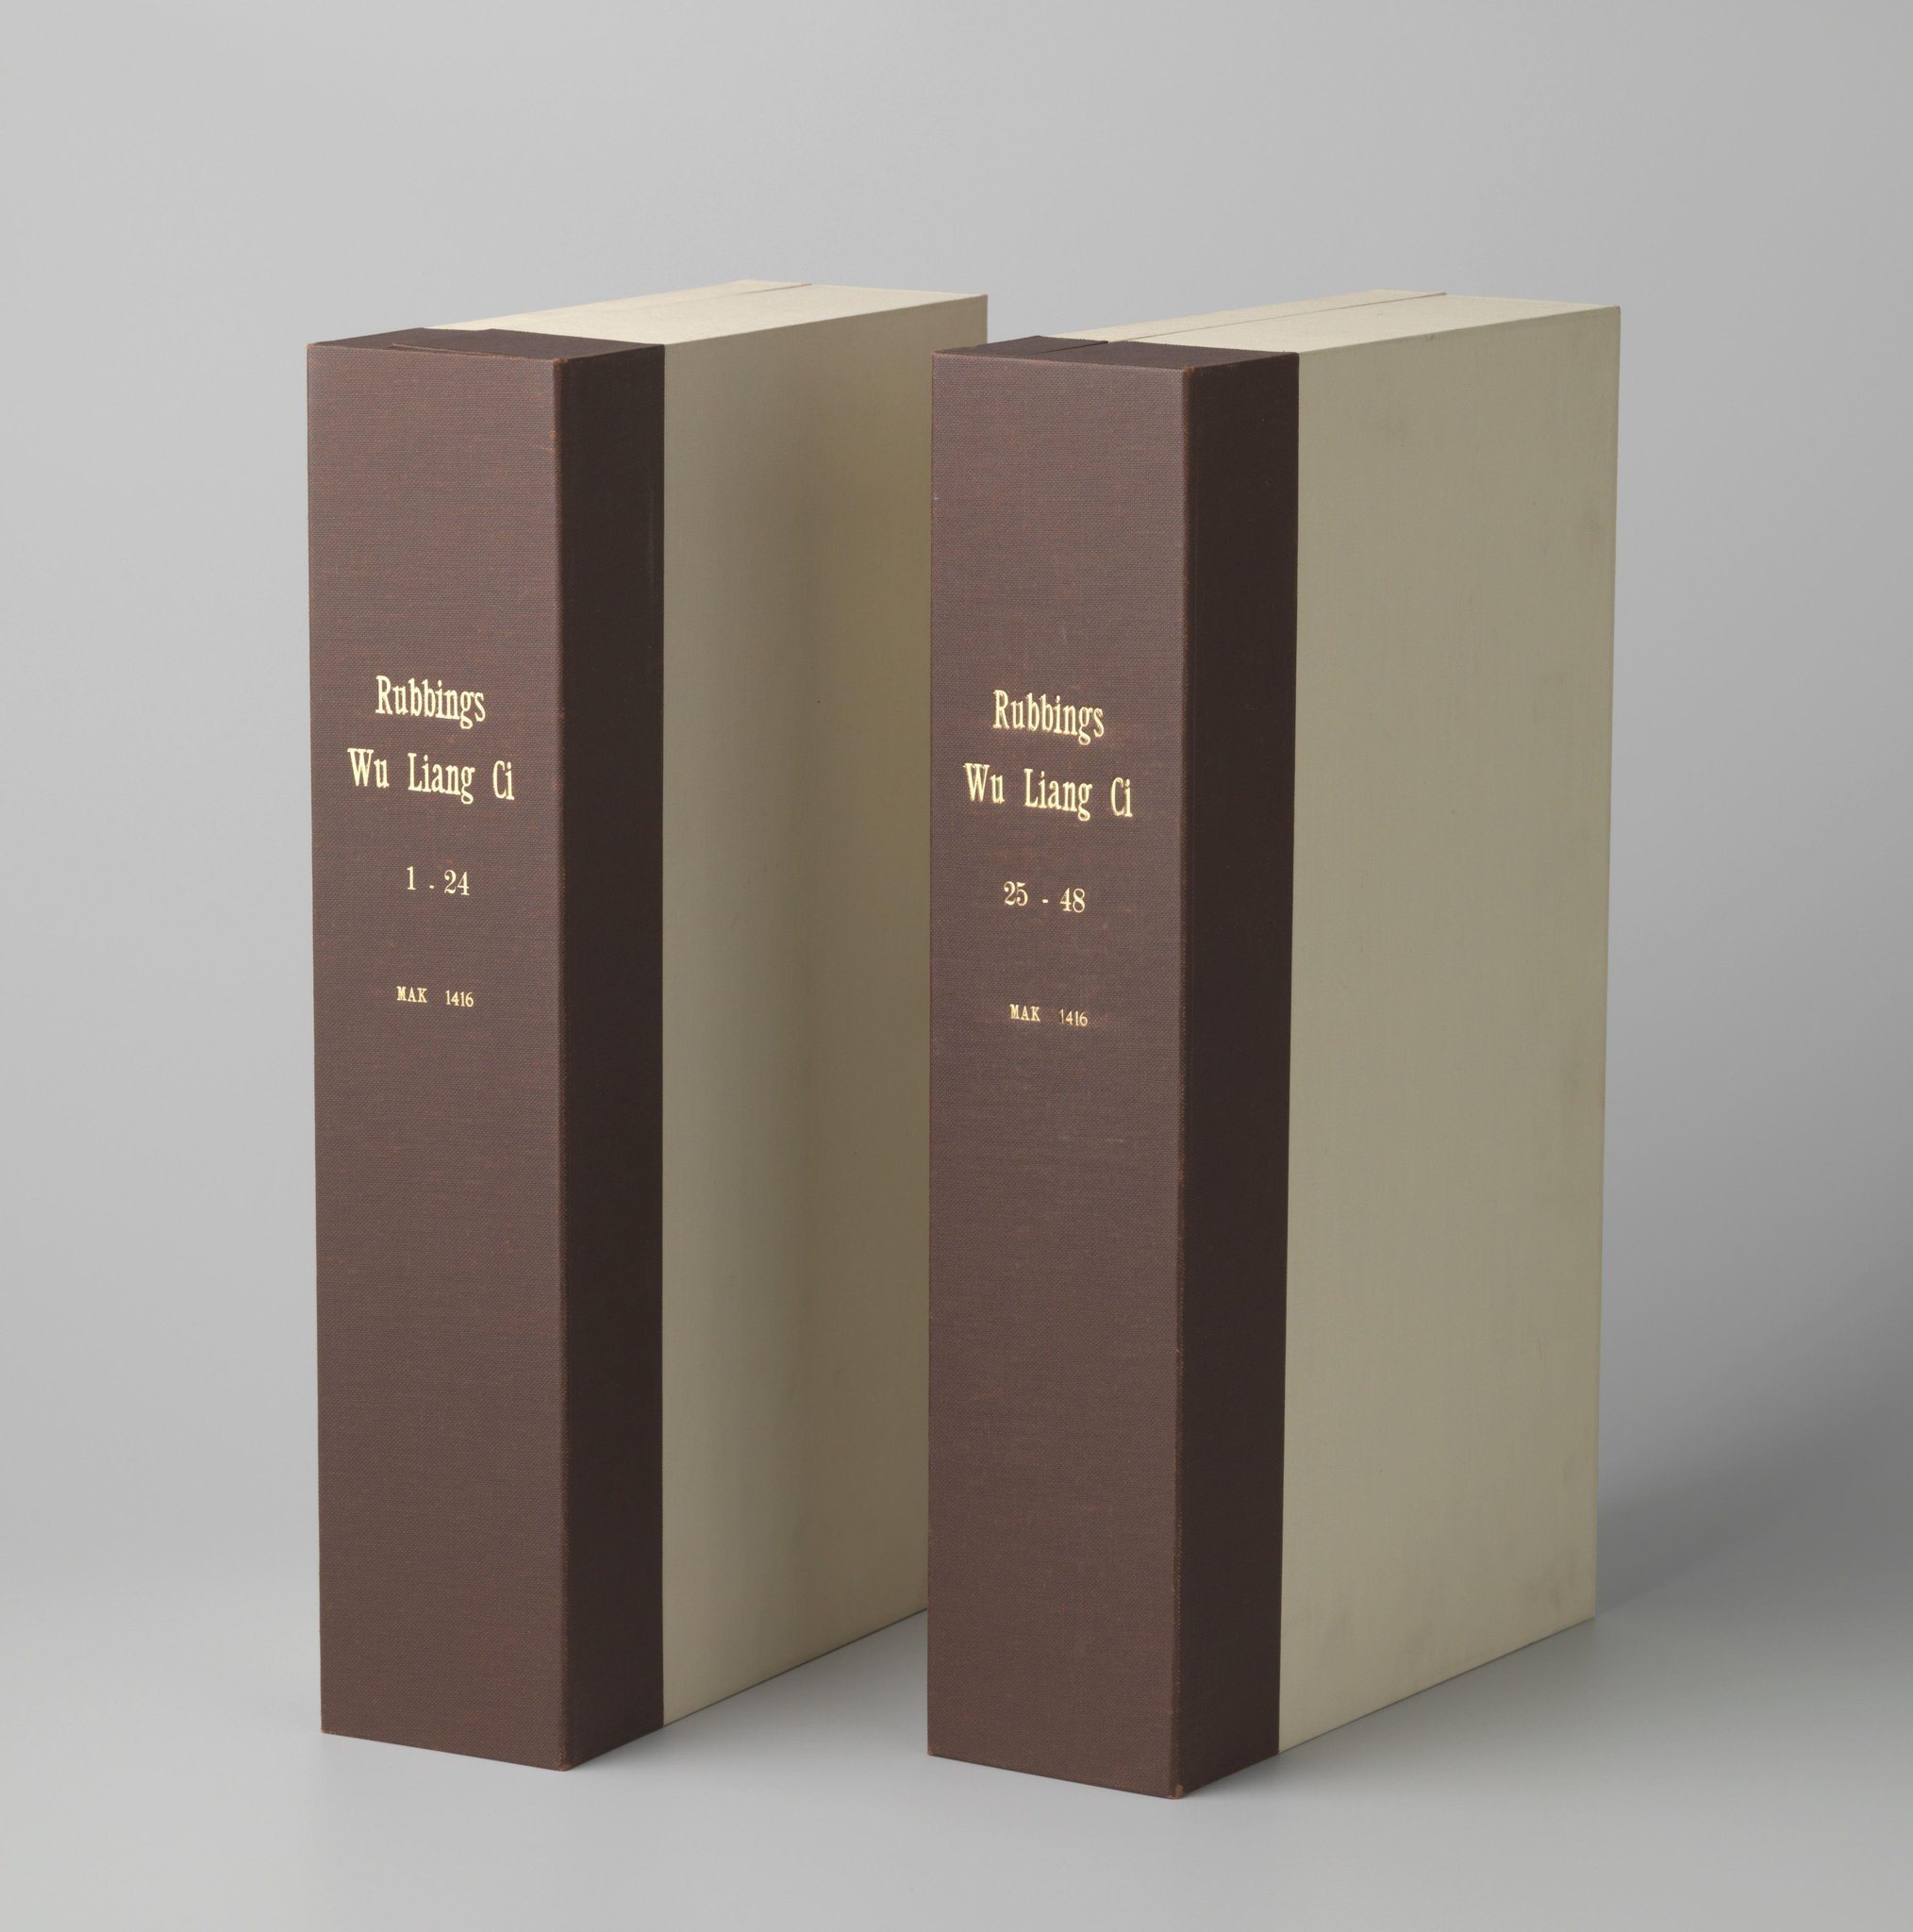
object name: wrijfprent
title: Twee albums met respectievelijk 25 en 24 wrijfprenten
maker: Anonymous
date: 150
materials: ink, paper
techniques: rubbing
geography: shandong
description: Rubbings van steenreliëf, de thema's zijn ontleend aan de geschiedenis, mythologie en religie van het voorboeddhistische China.